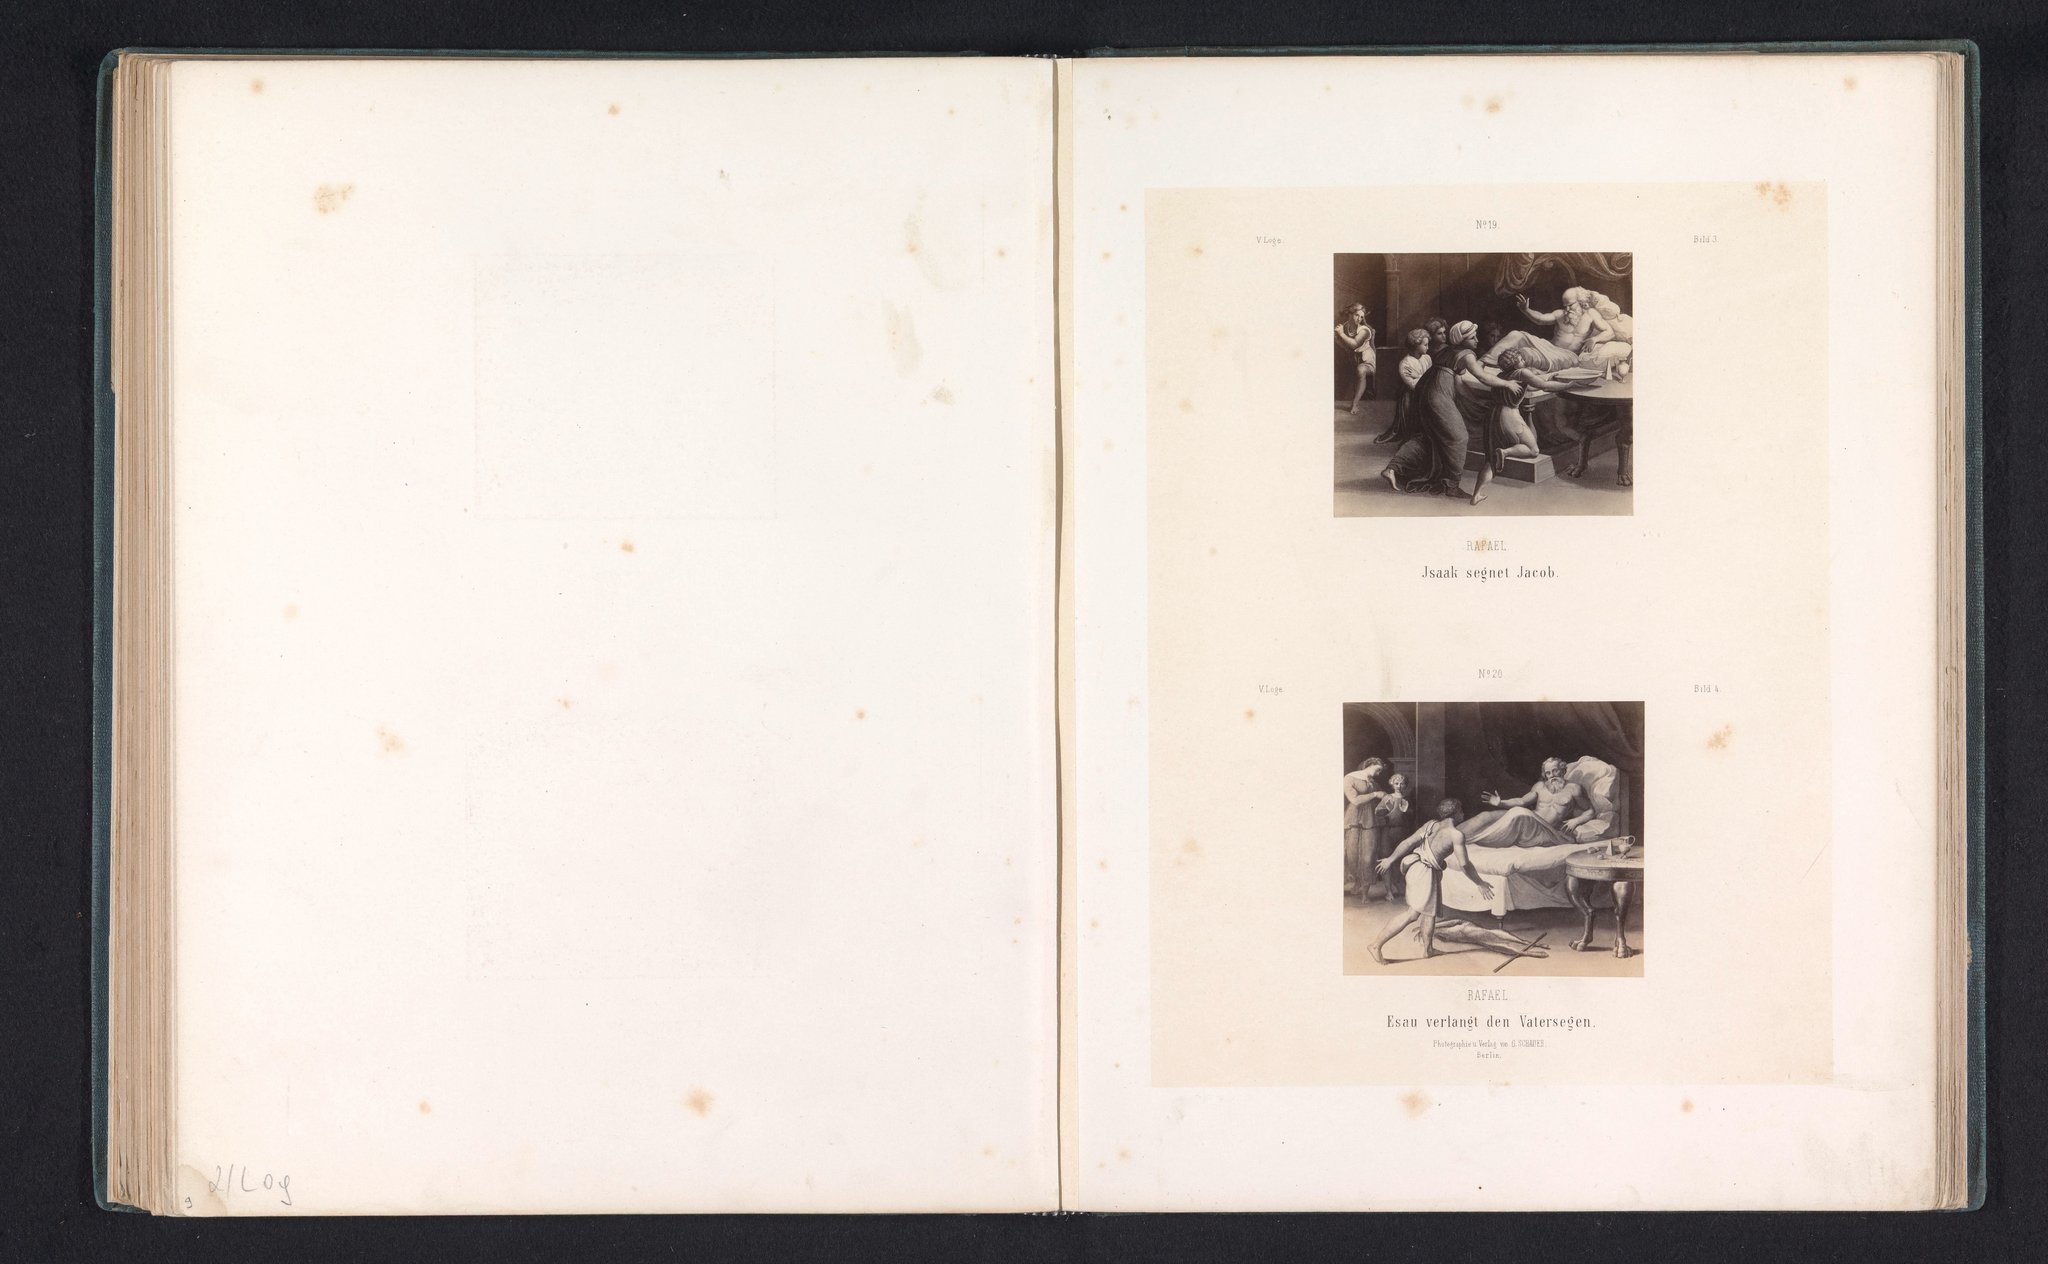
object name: page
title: Fotoreproducties van prenten naar fresco's met voorstellingen van Isaak die Jacob zegent en Esau die vraagt om zegening door Rafaël voor de loggia's in het Vaticaan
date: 1851-1861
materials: photographic support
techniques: albumen print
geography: berlin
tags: esau seeks his father's blessing; isaac realizes he has mistakenly blessed jacob instead of esau, isaac sitting in bed blesses jacob who, disguised in esau's clothes, brings food to his father; jacob's hands and neck are covered with goatskins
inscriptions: number: ‘No 19. No 20. Bild 3. Bild 4. V. Loge.’